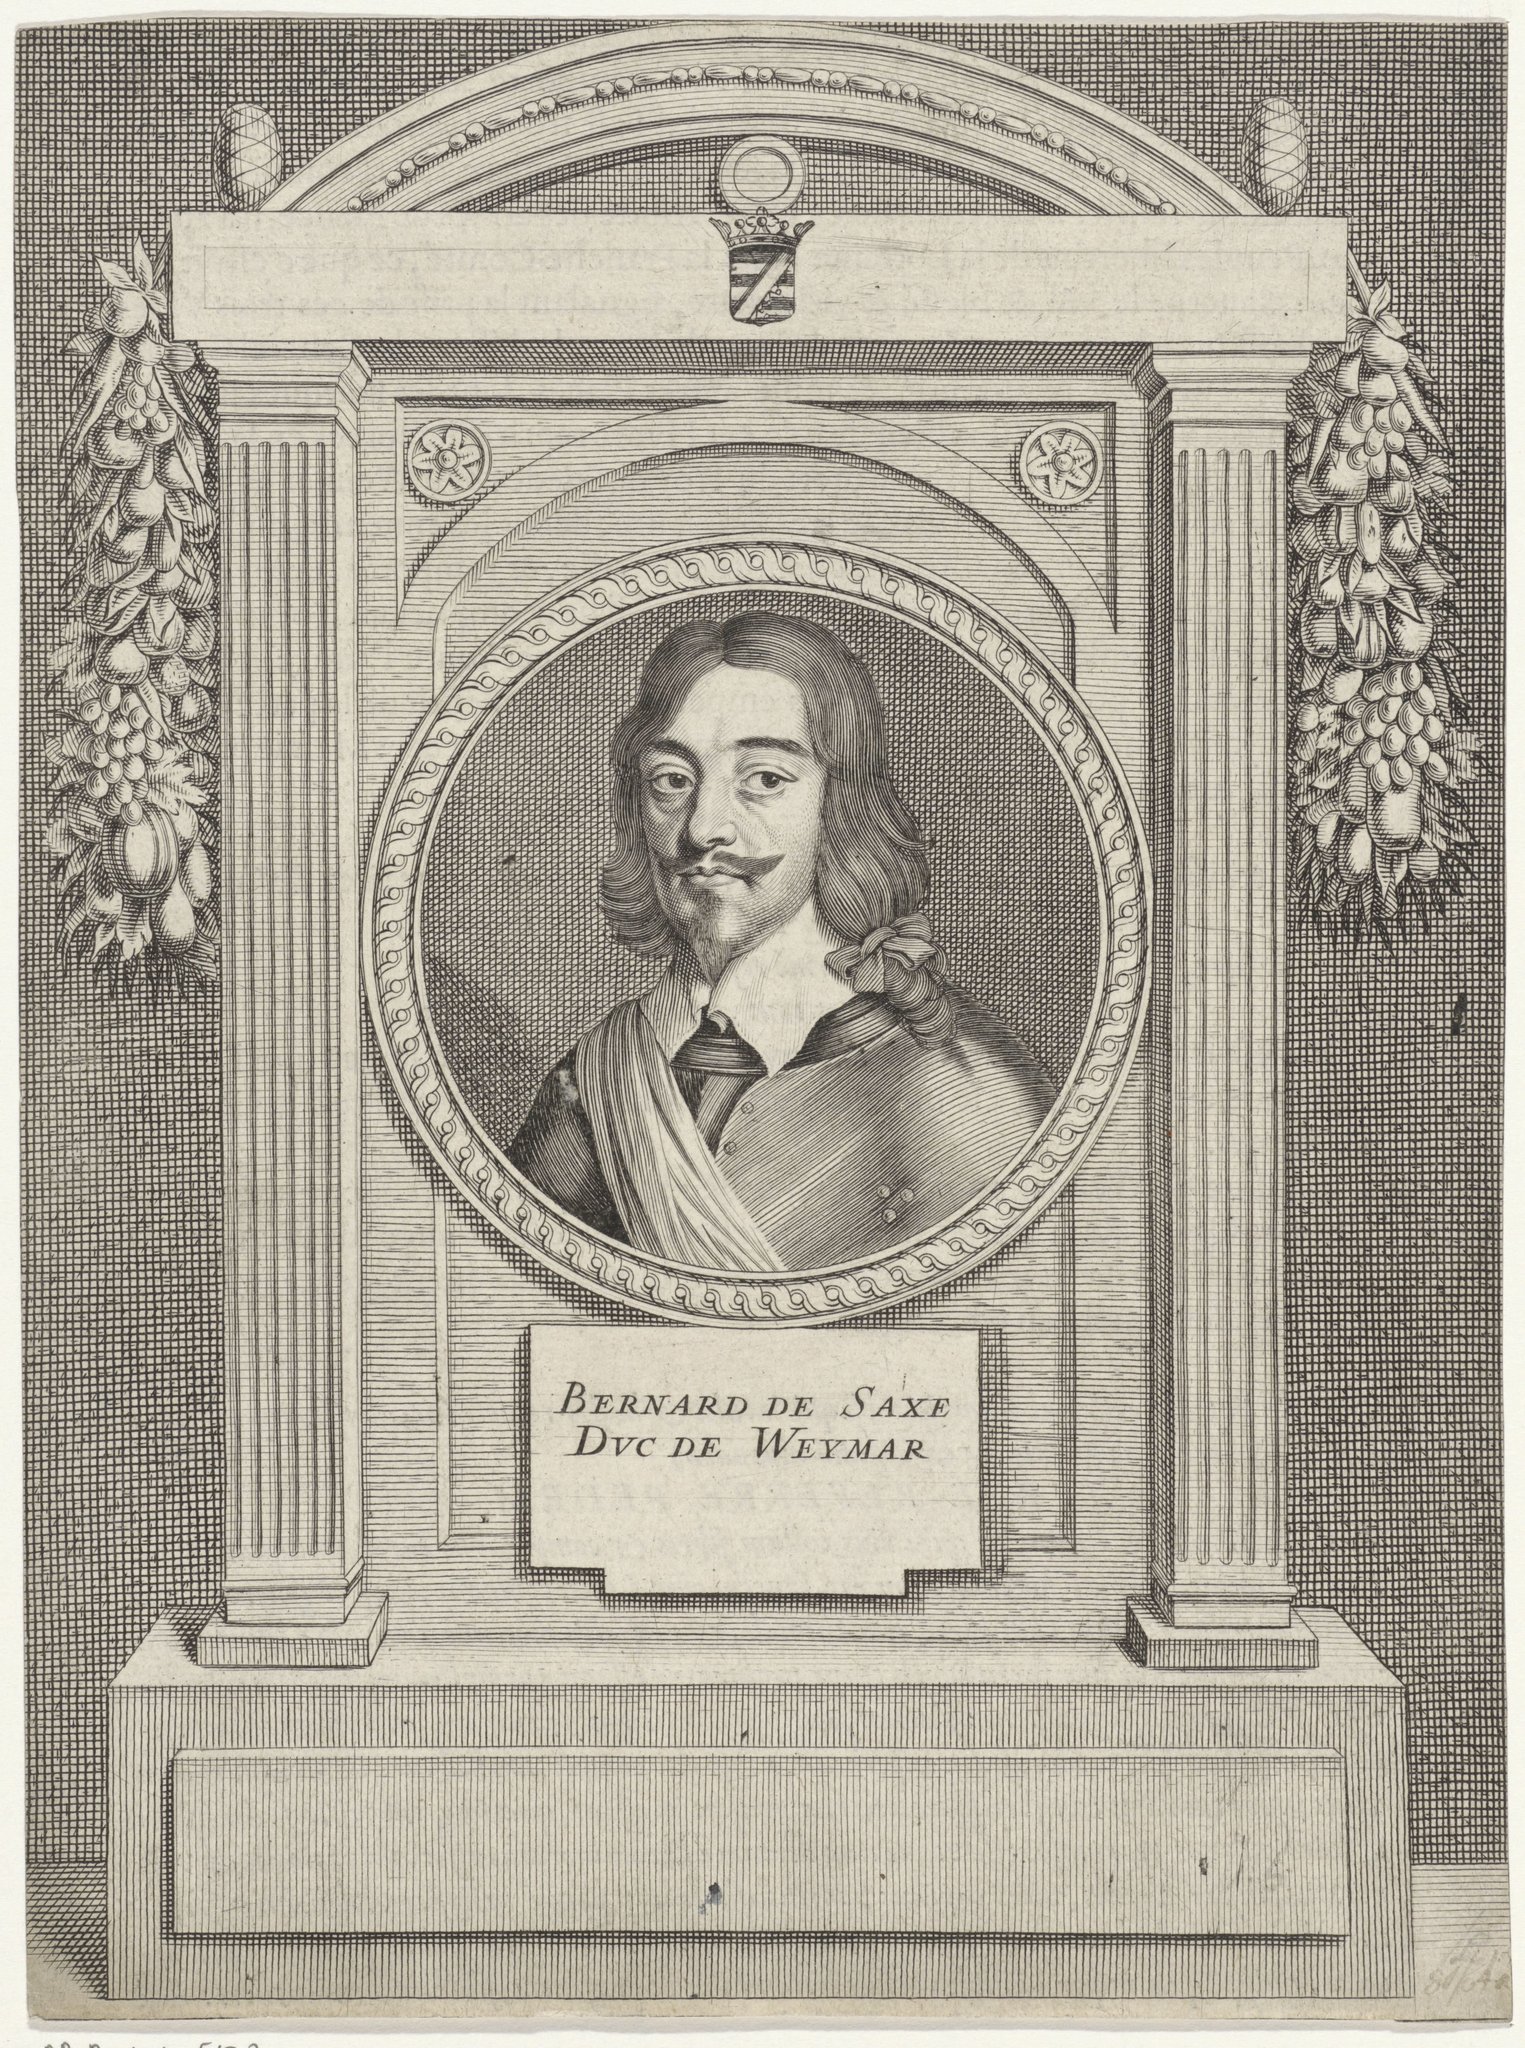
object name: book illustration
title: Portret van Bernhard, hertog van Saksen-Weimar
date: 1649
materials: paper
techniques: engraving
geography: paris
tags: lodewijk xiii (koning van frankrijk)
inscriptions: collector's mark: Lugt 2228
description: Boekillustratie in: Estienne, Henry. Devises des roys, princes et generaux d'armees qui ont assiste ou servy Louis le Juste combattant. In: Les Triomphes de Louis le Juste XIII. Parijs: A. Estienne, 1649.